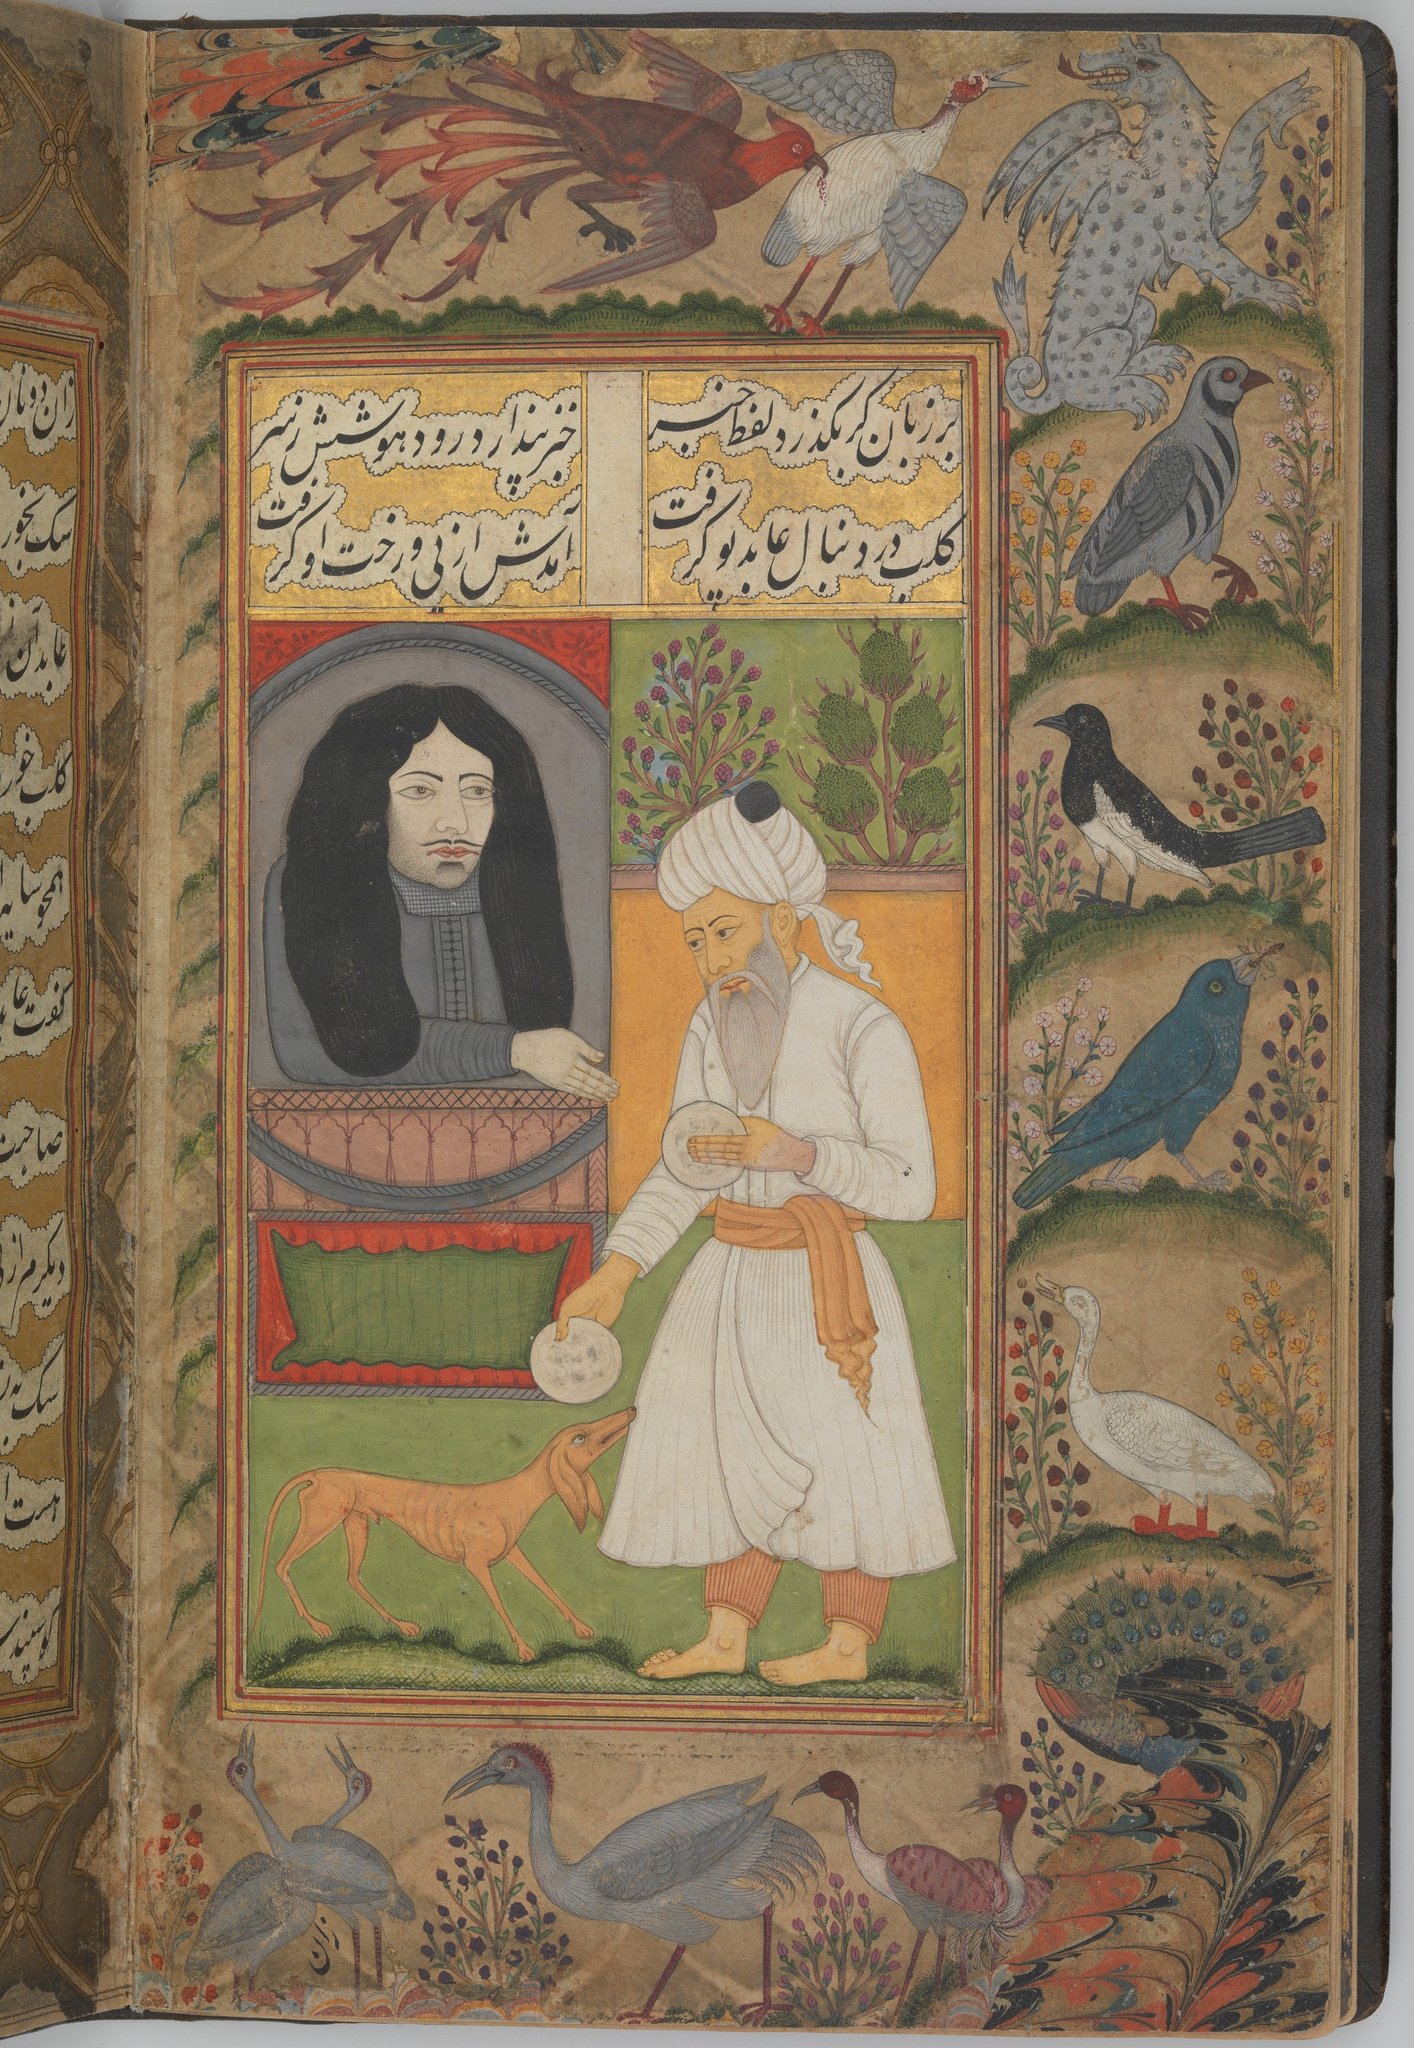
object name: illustrated manuscript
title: Nan va Halva (Breads and Sweets)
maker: muhammad baha' al-din al-'amili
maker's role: author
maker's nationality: iranian, born syria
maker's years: 1547-1621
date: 1690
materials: gold, ink, leather, paper, watercolor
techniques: bookbinding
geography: india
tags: birds,men,dogs